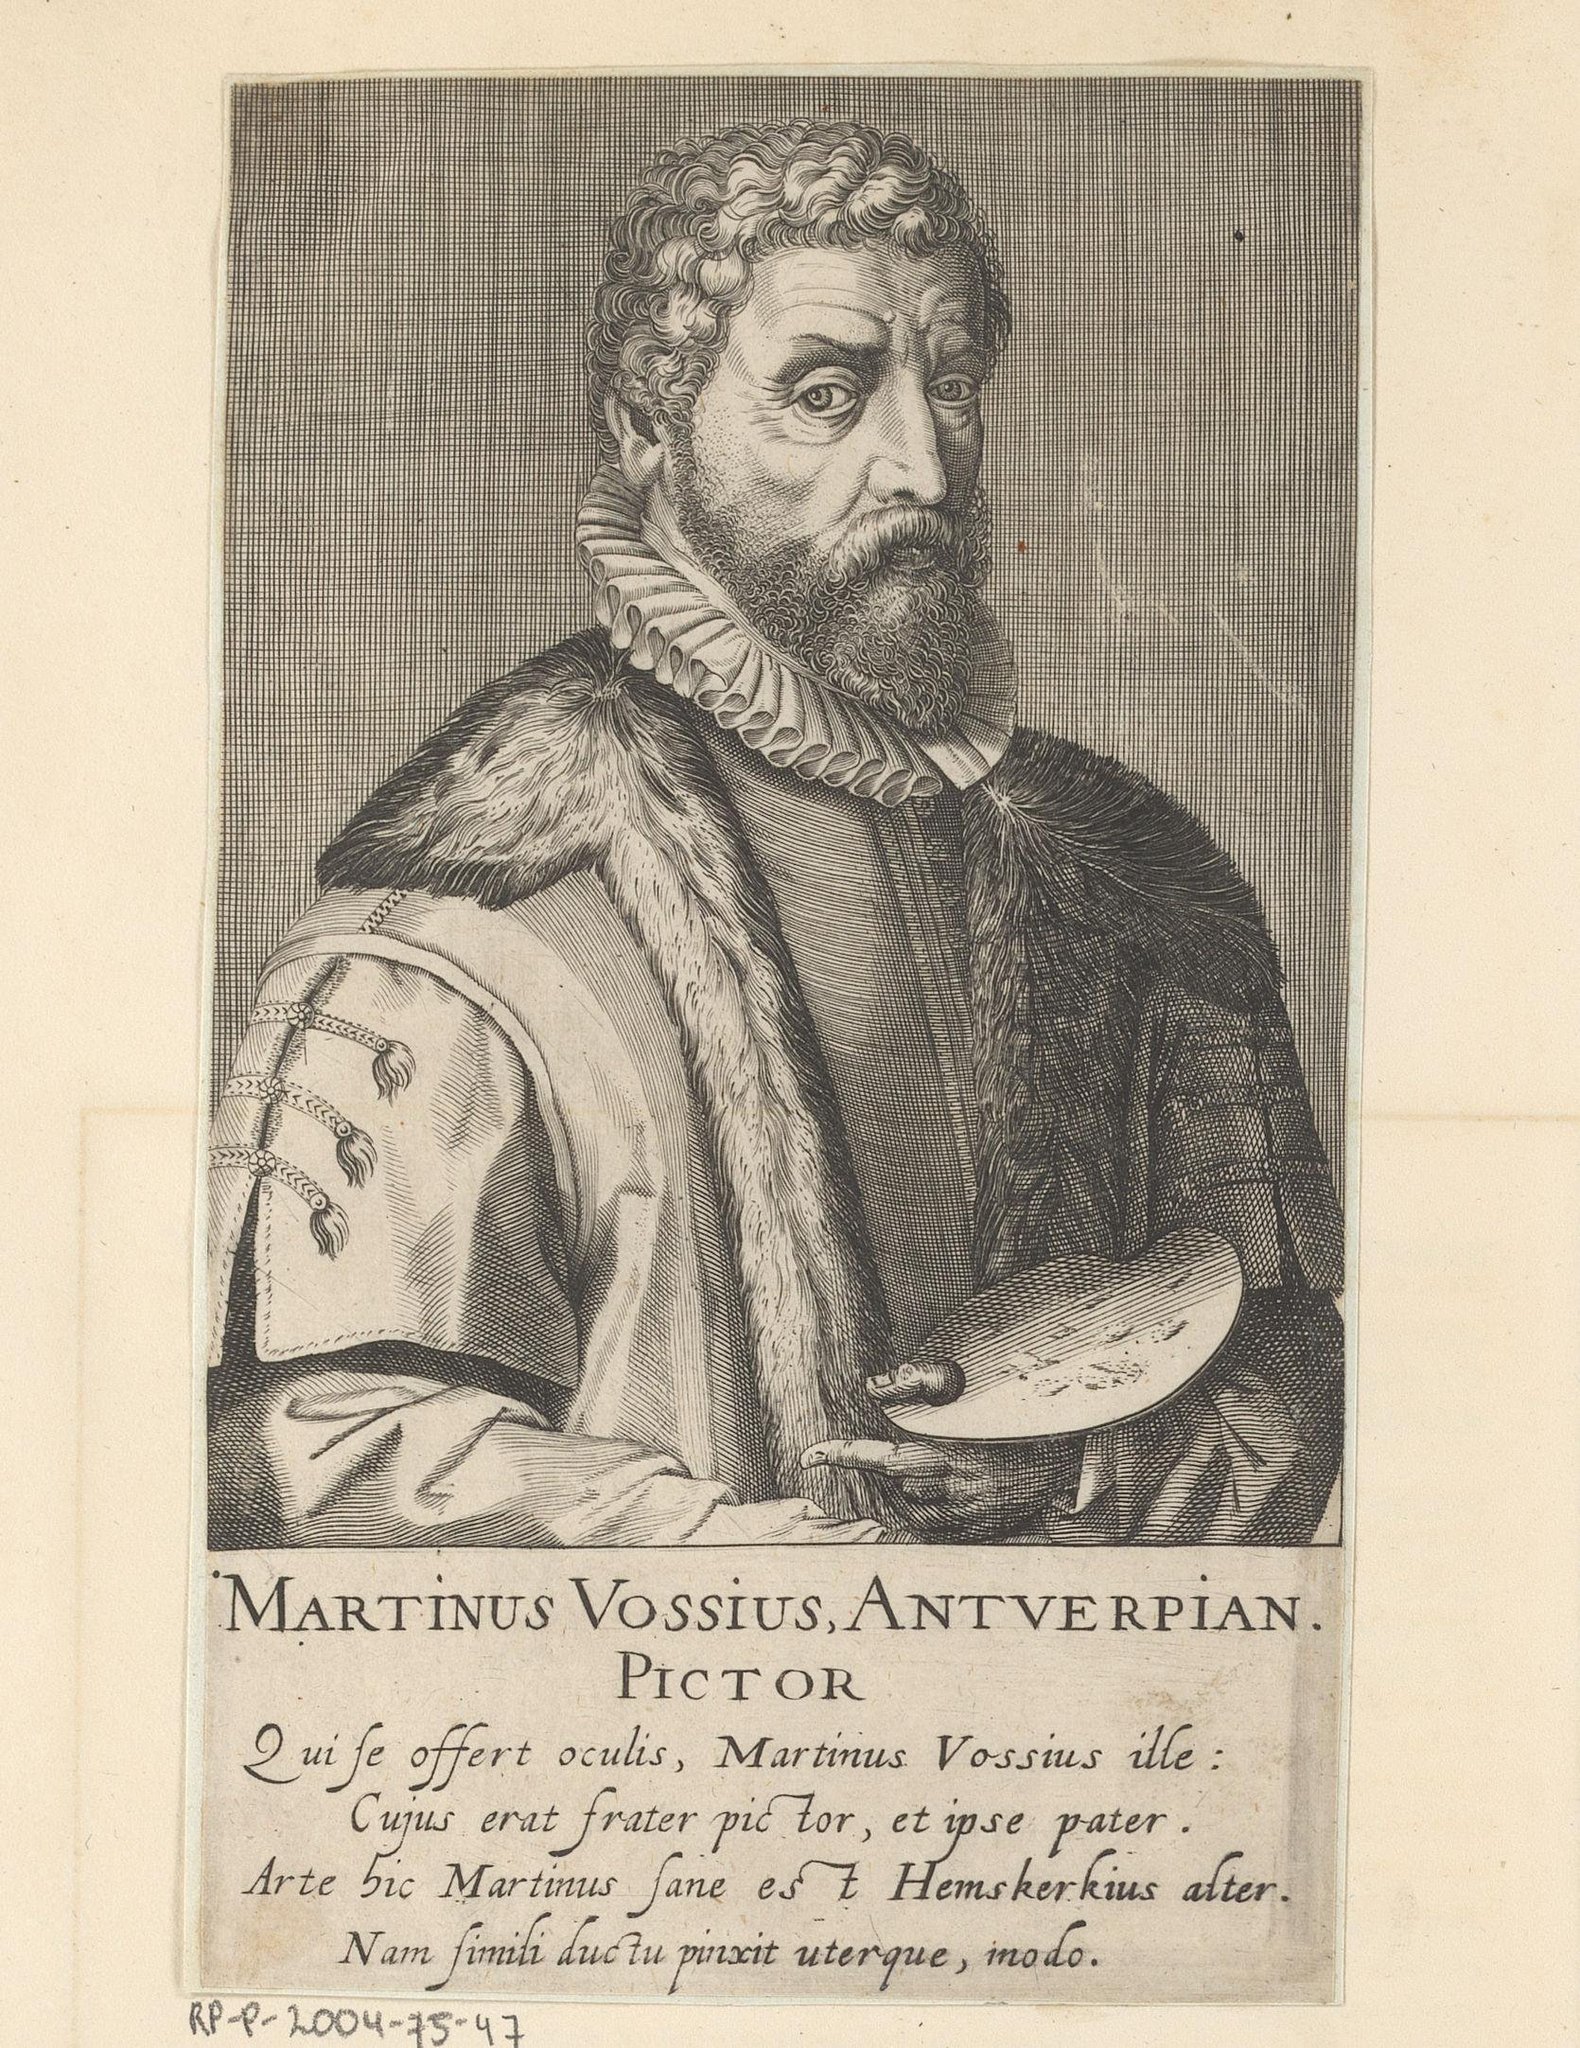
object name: album leaf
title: Martinus Vossius, Antverpian Pictor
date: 1610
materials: paper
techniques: engraving, etching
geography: the hague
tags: antwerp, maerten de vos, historical persons, portrait, self-portrait of painter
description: De samensteller heeft deze prent in het album geplakt als illustratie bij: Pilkington, Matthew en Johann Heinrich Füssli. A dictionary of painters, from the revival of the art to the present period. 4 dln. Londen: John Crowder, 1805, dl. 4, p. 629.